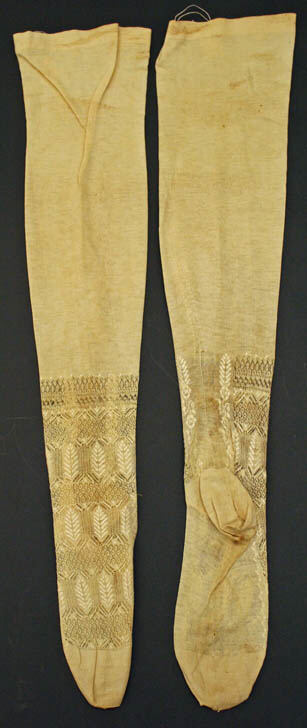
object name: stocking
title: Stockings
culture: american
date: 1873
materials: cotton